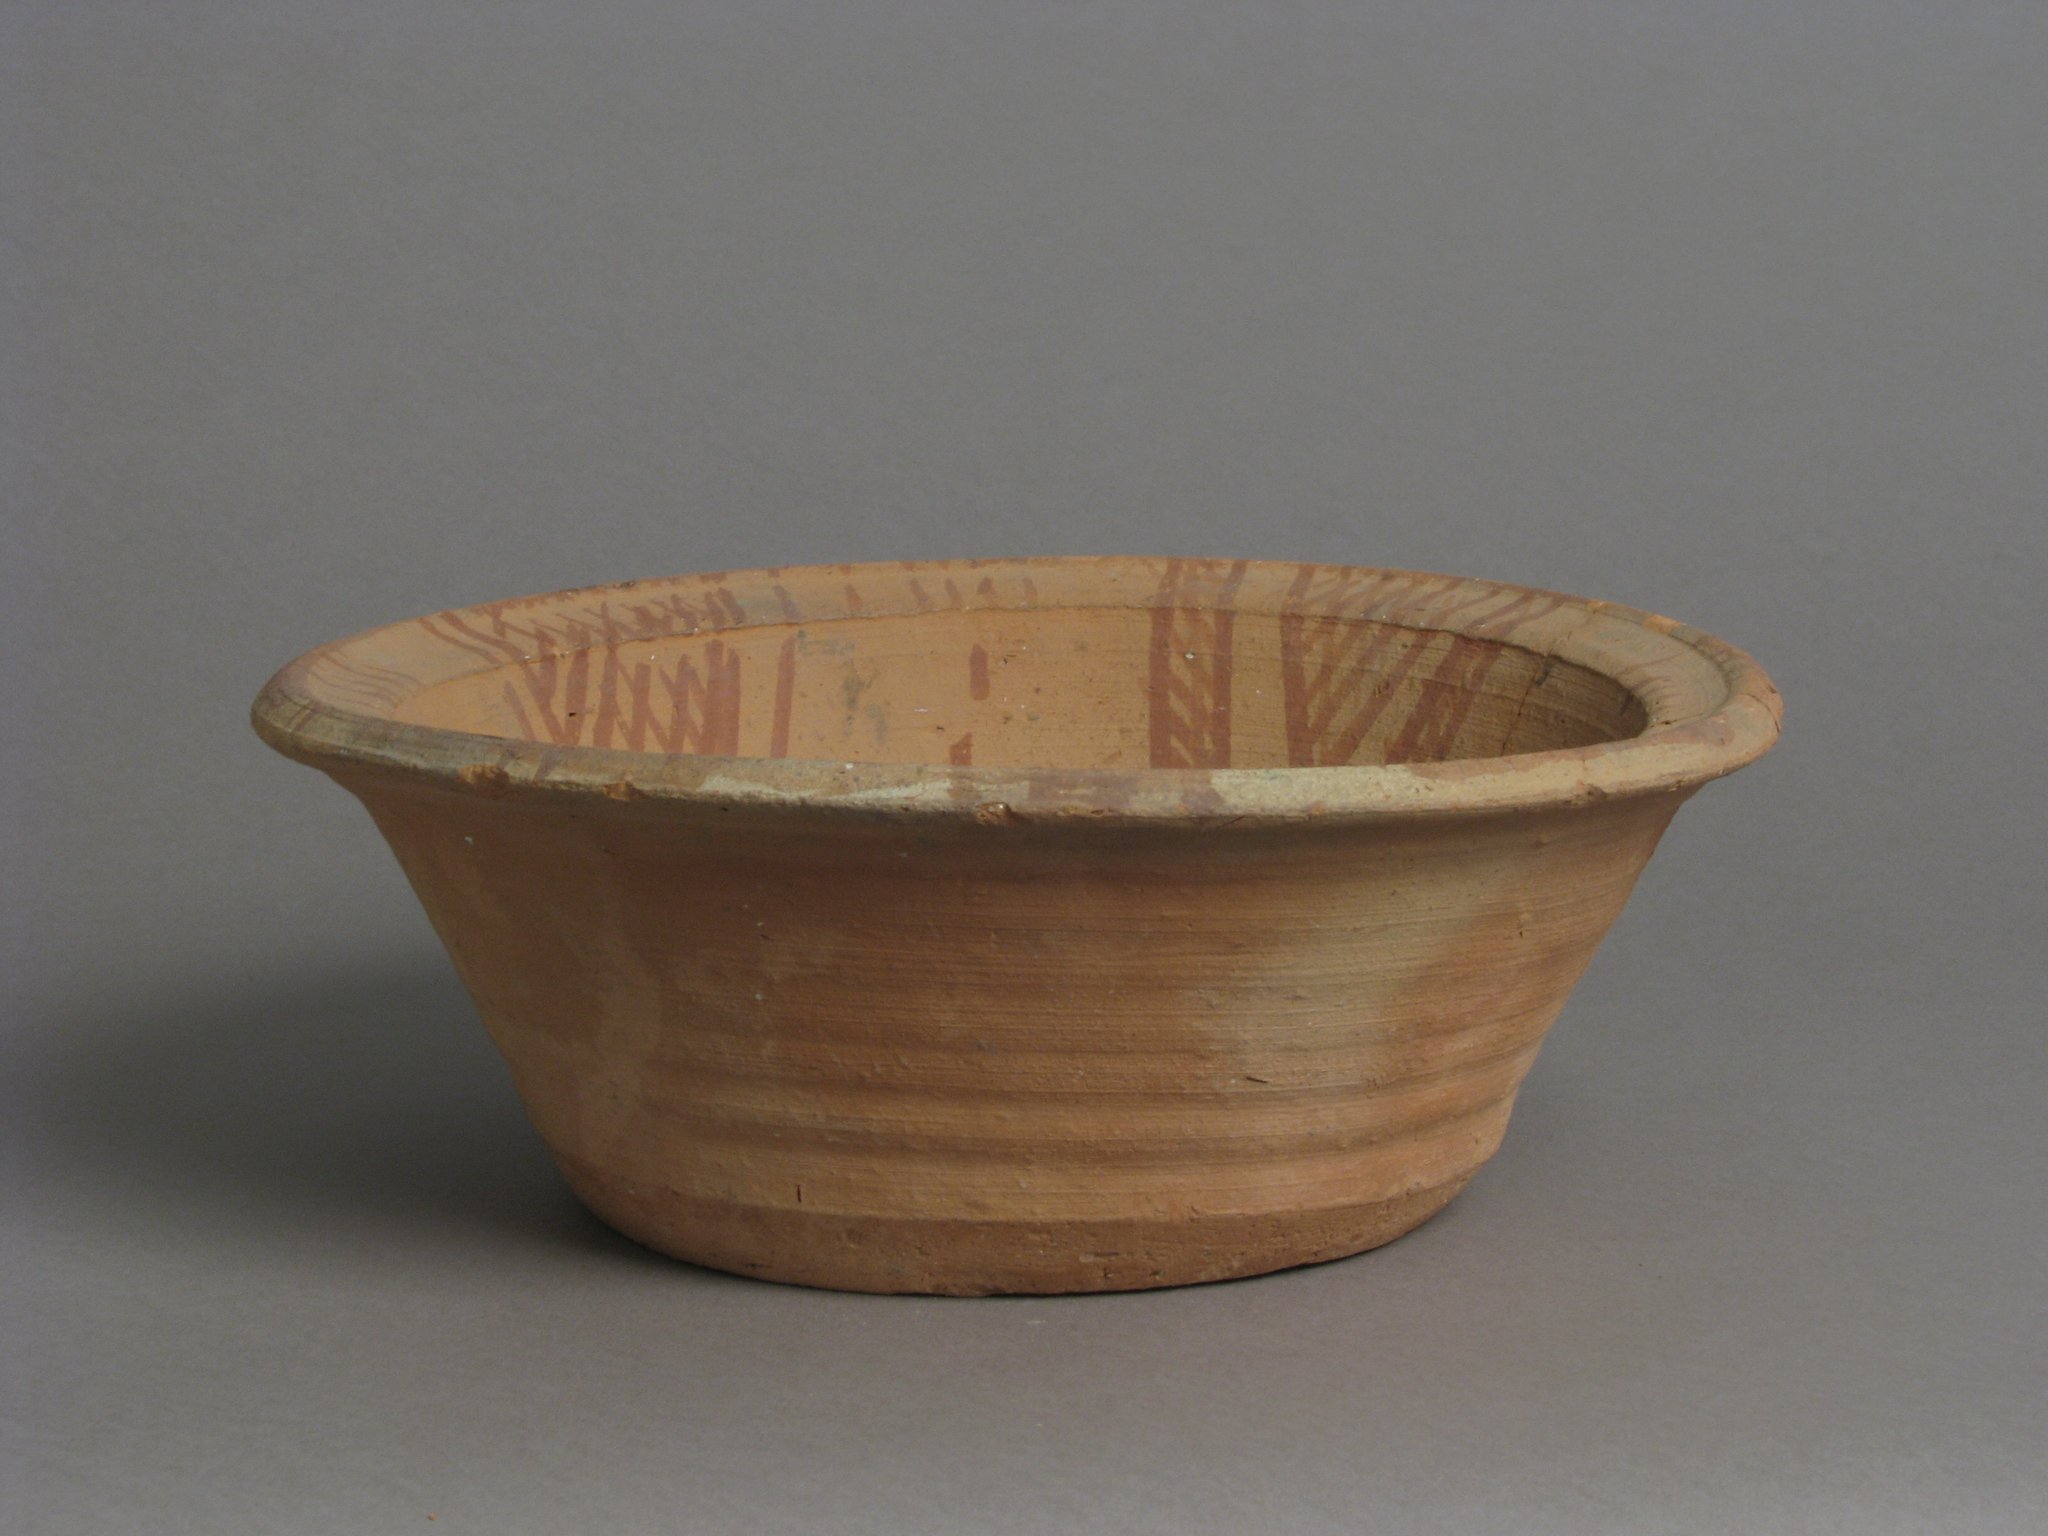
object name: bowl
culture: coptic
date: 301-700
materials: earthenware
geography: egypt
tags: bowls